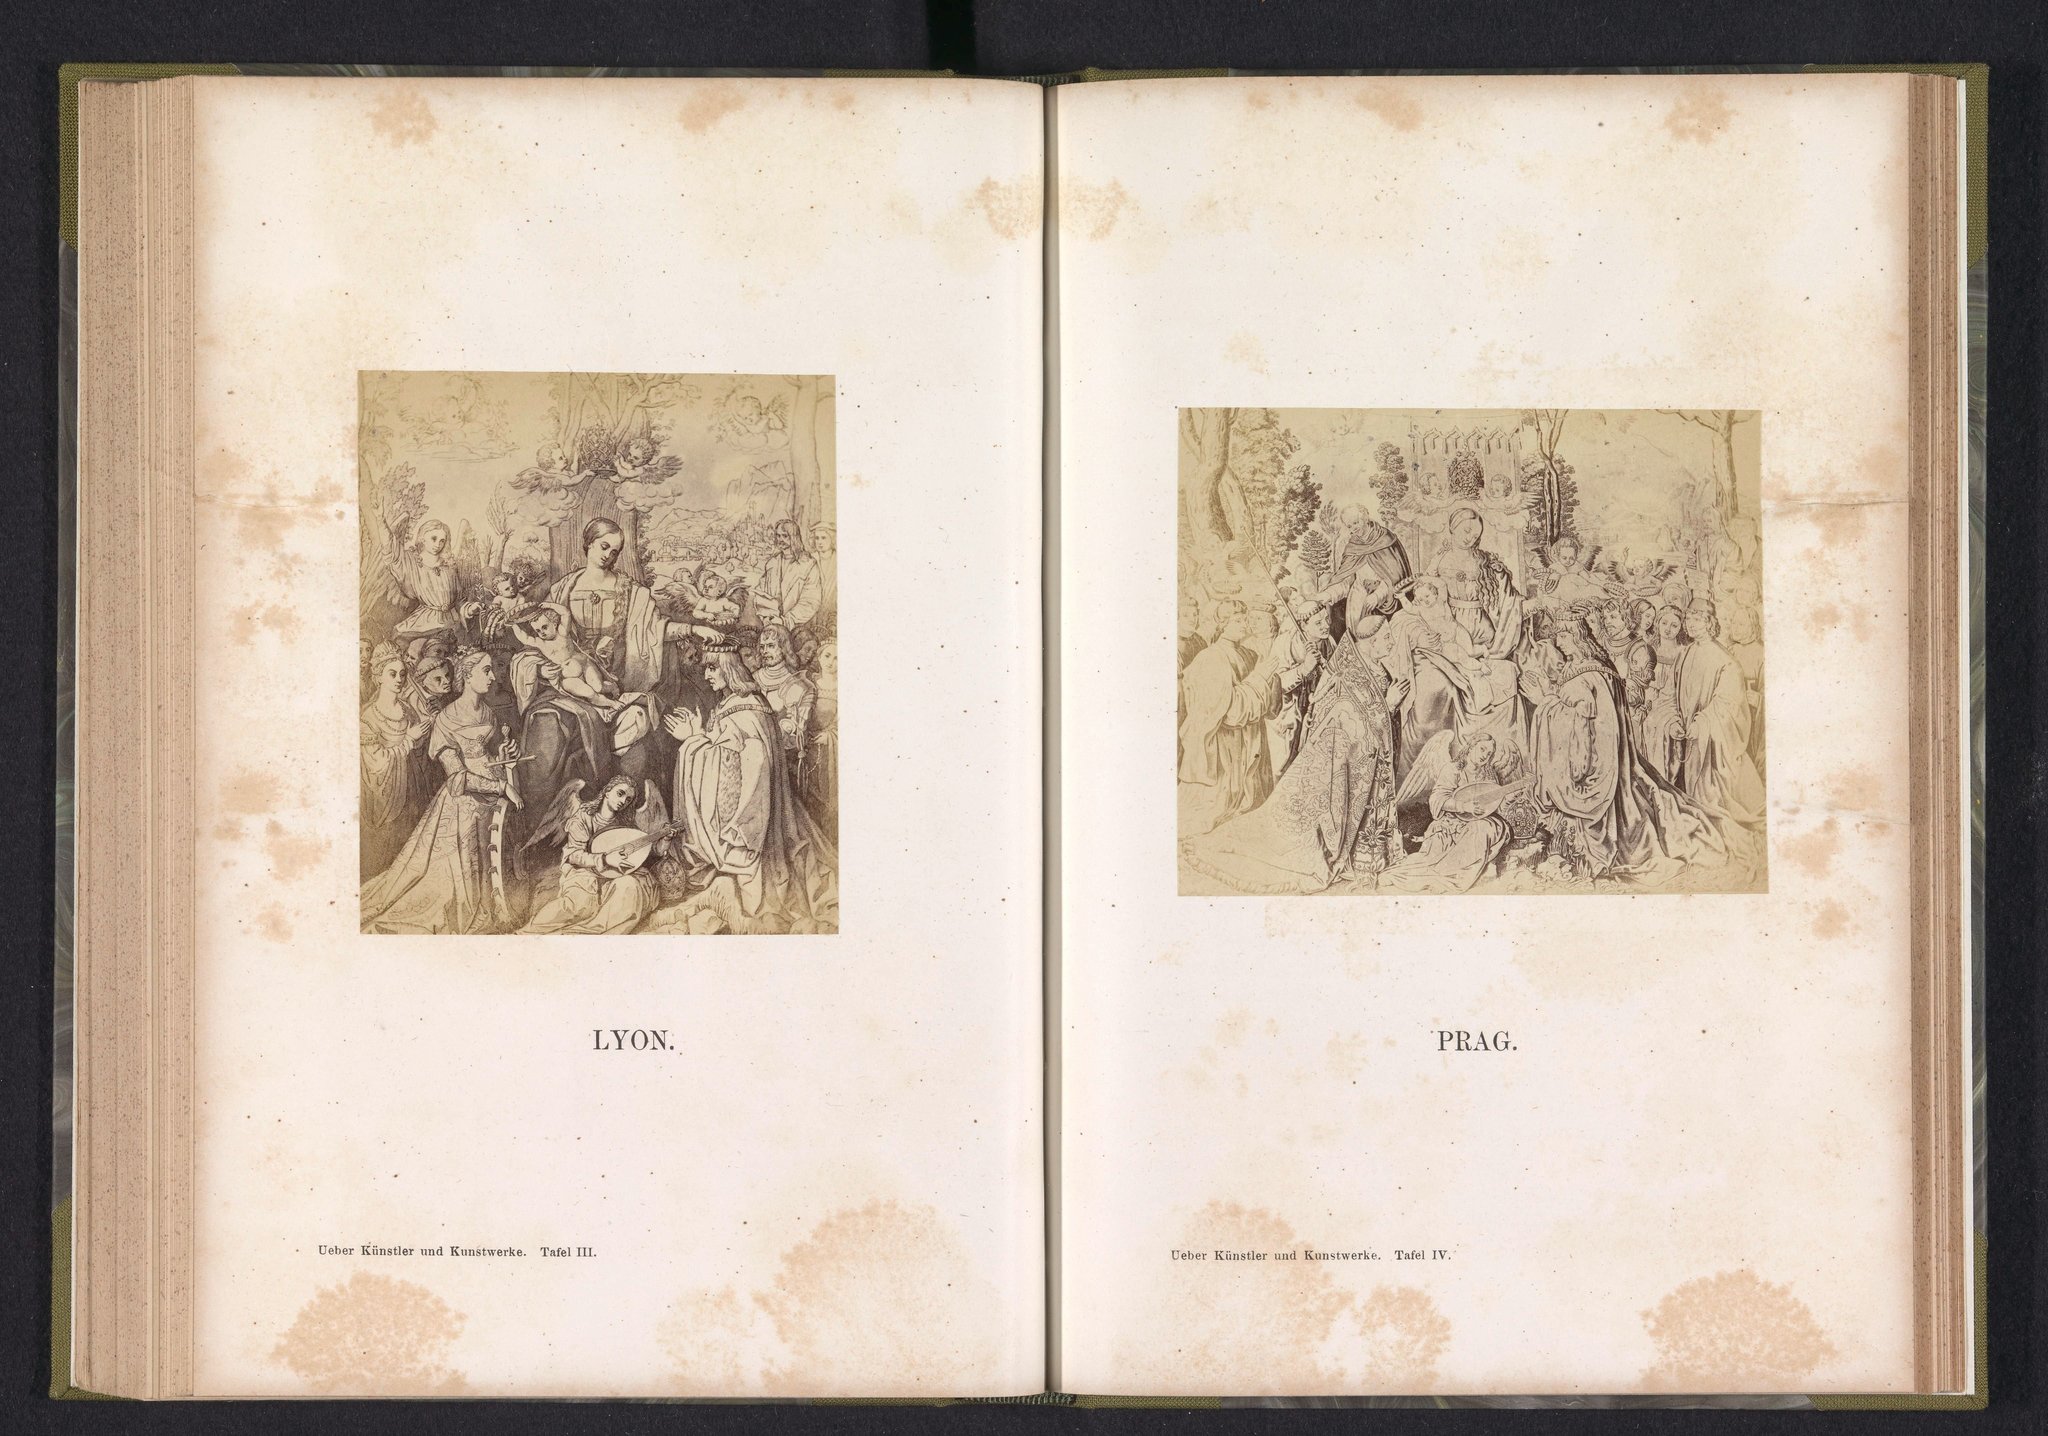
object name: page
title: Fotoreproductie van een prent naar een schilderij, voorstellende het Feest van de Heilige Rozenkrans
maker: Anonymous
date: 1860-1865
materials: photographic support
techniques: albumen print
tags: madonna of the rosary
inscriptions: number: ‘Tafel III.’